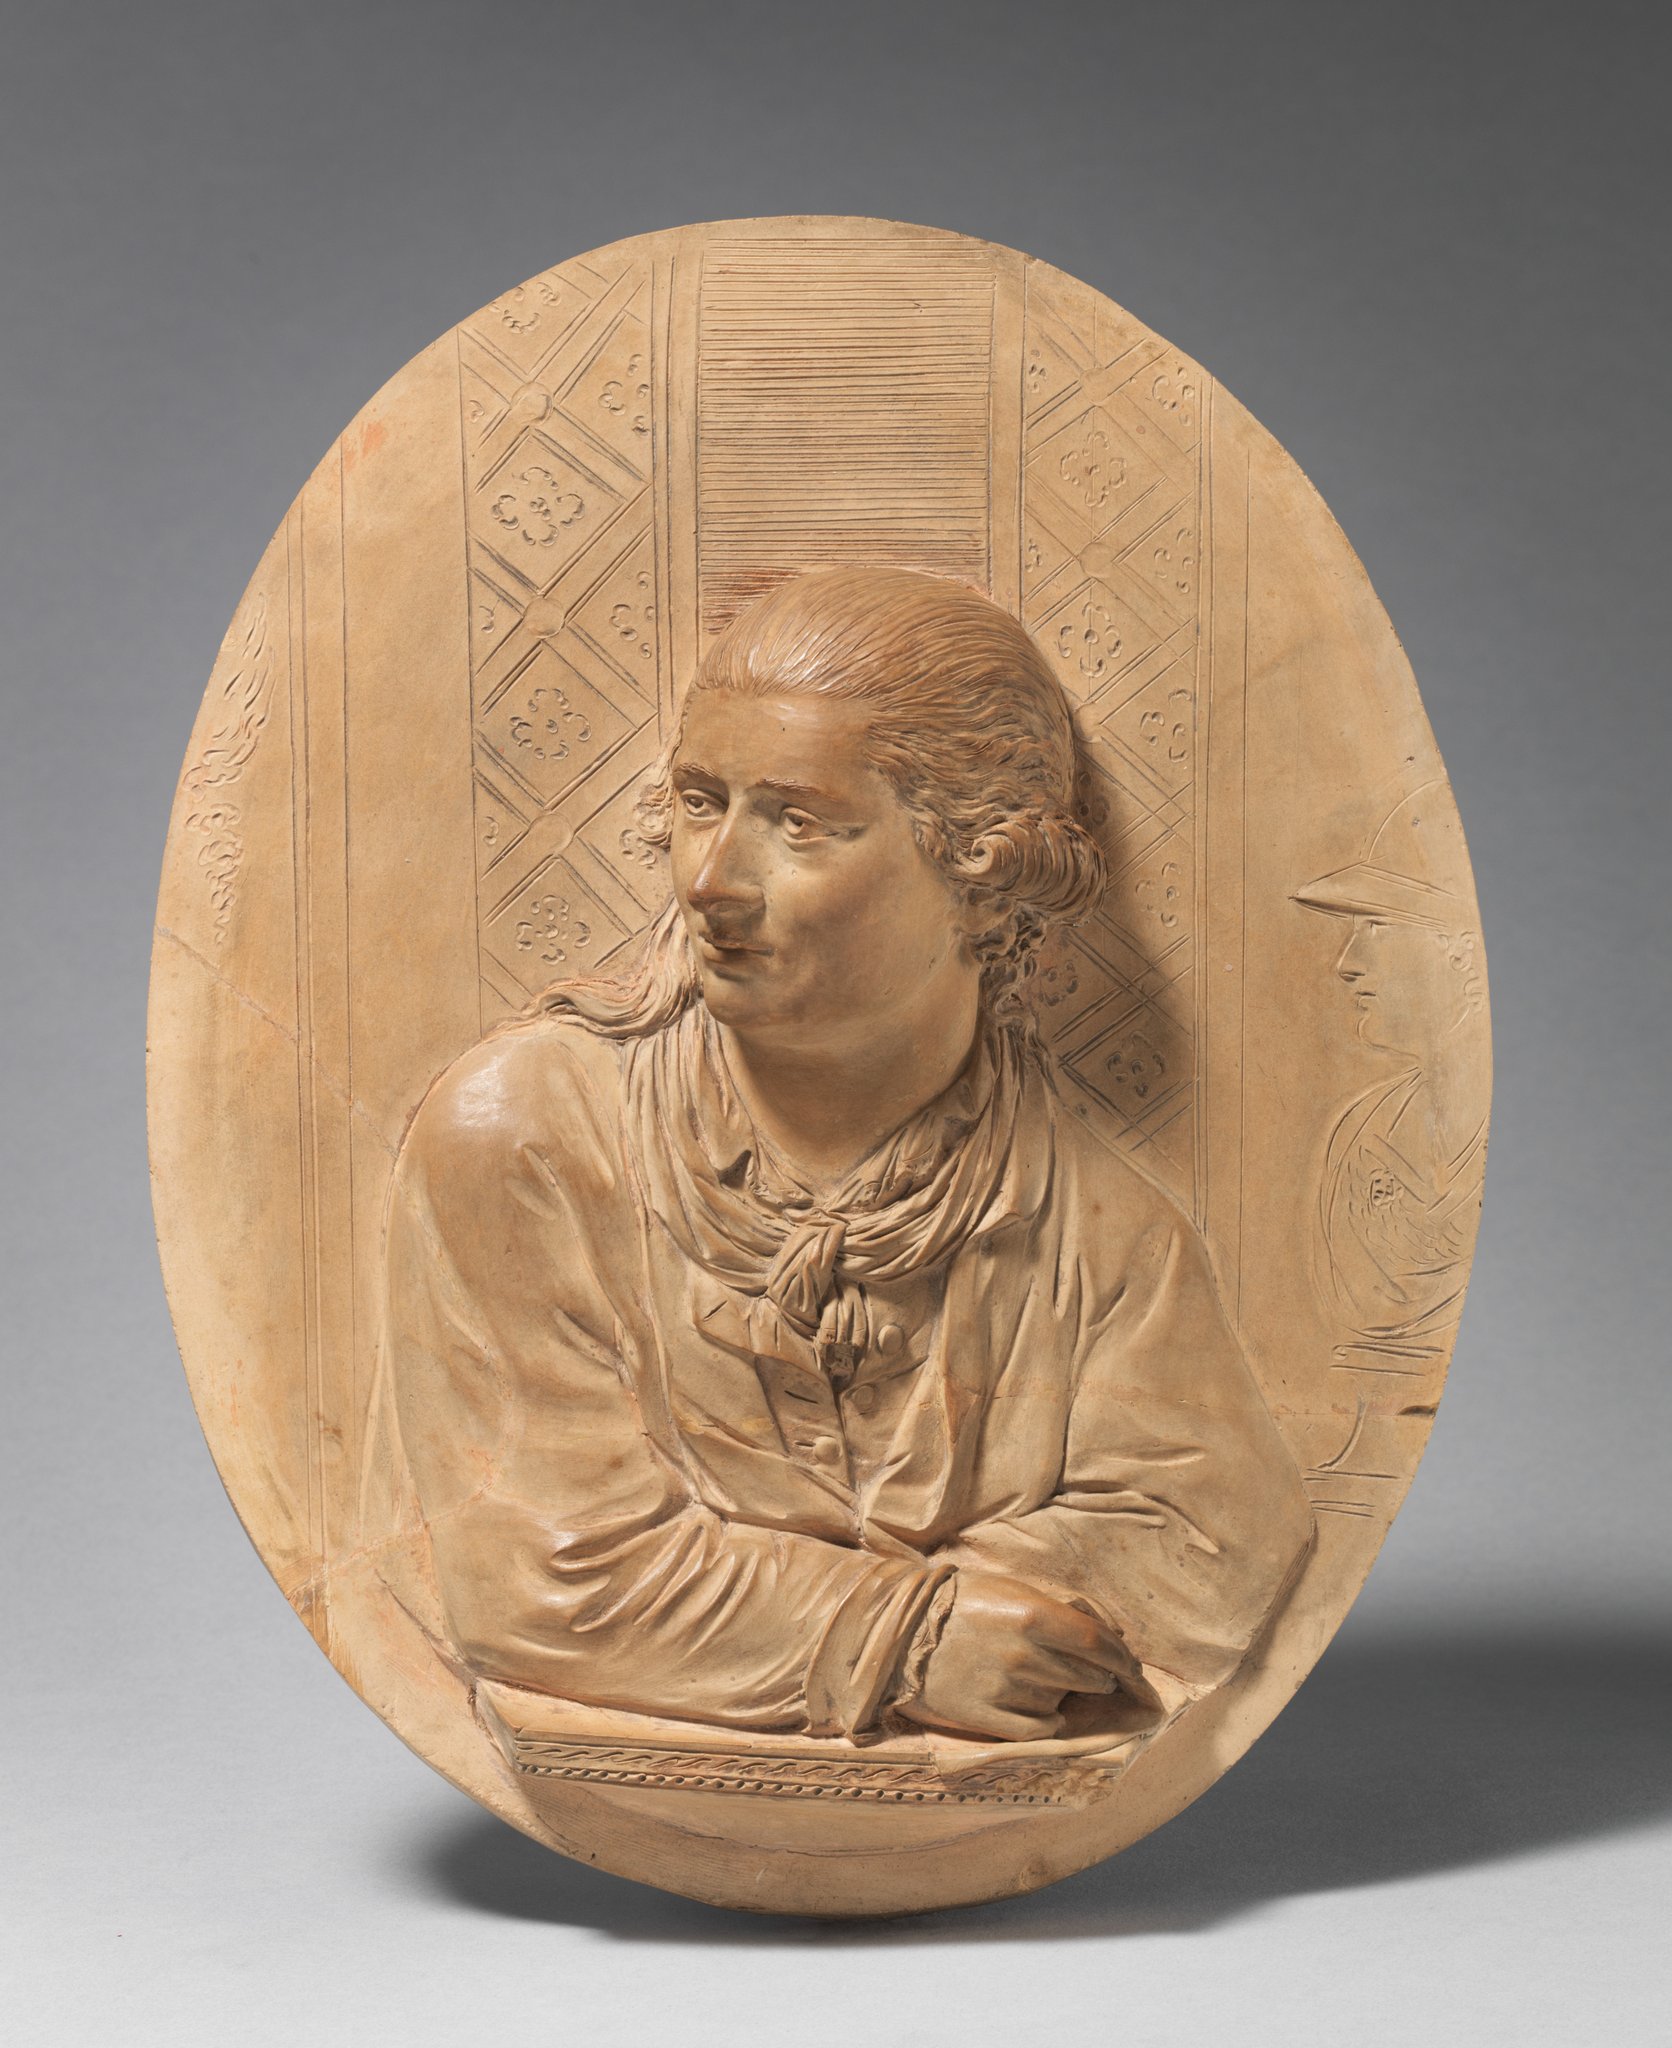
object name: portrait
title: Portrait of a poet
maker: johann valentin sonnenschein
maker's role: maker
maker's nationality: swiss, born germany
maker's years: 1749-1828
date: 1767-1833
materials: terracotta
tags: men,portraits,poets